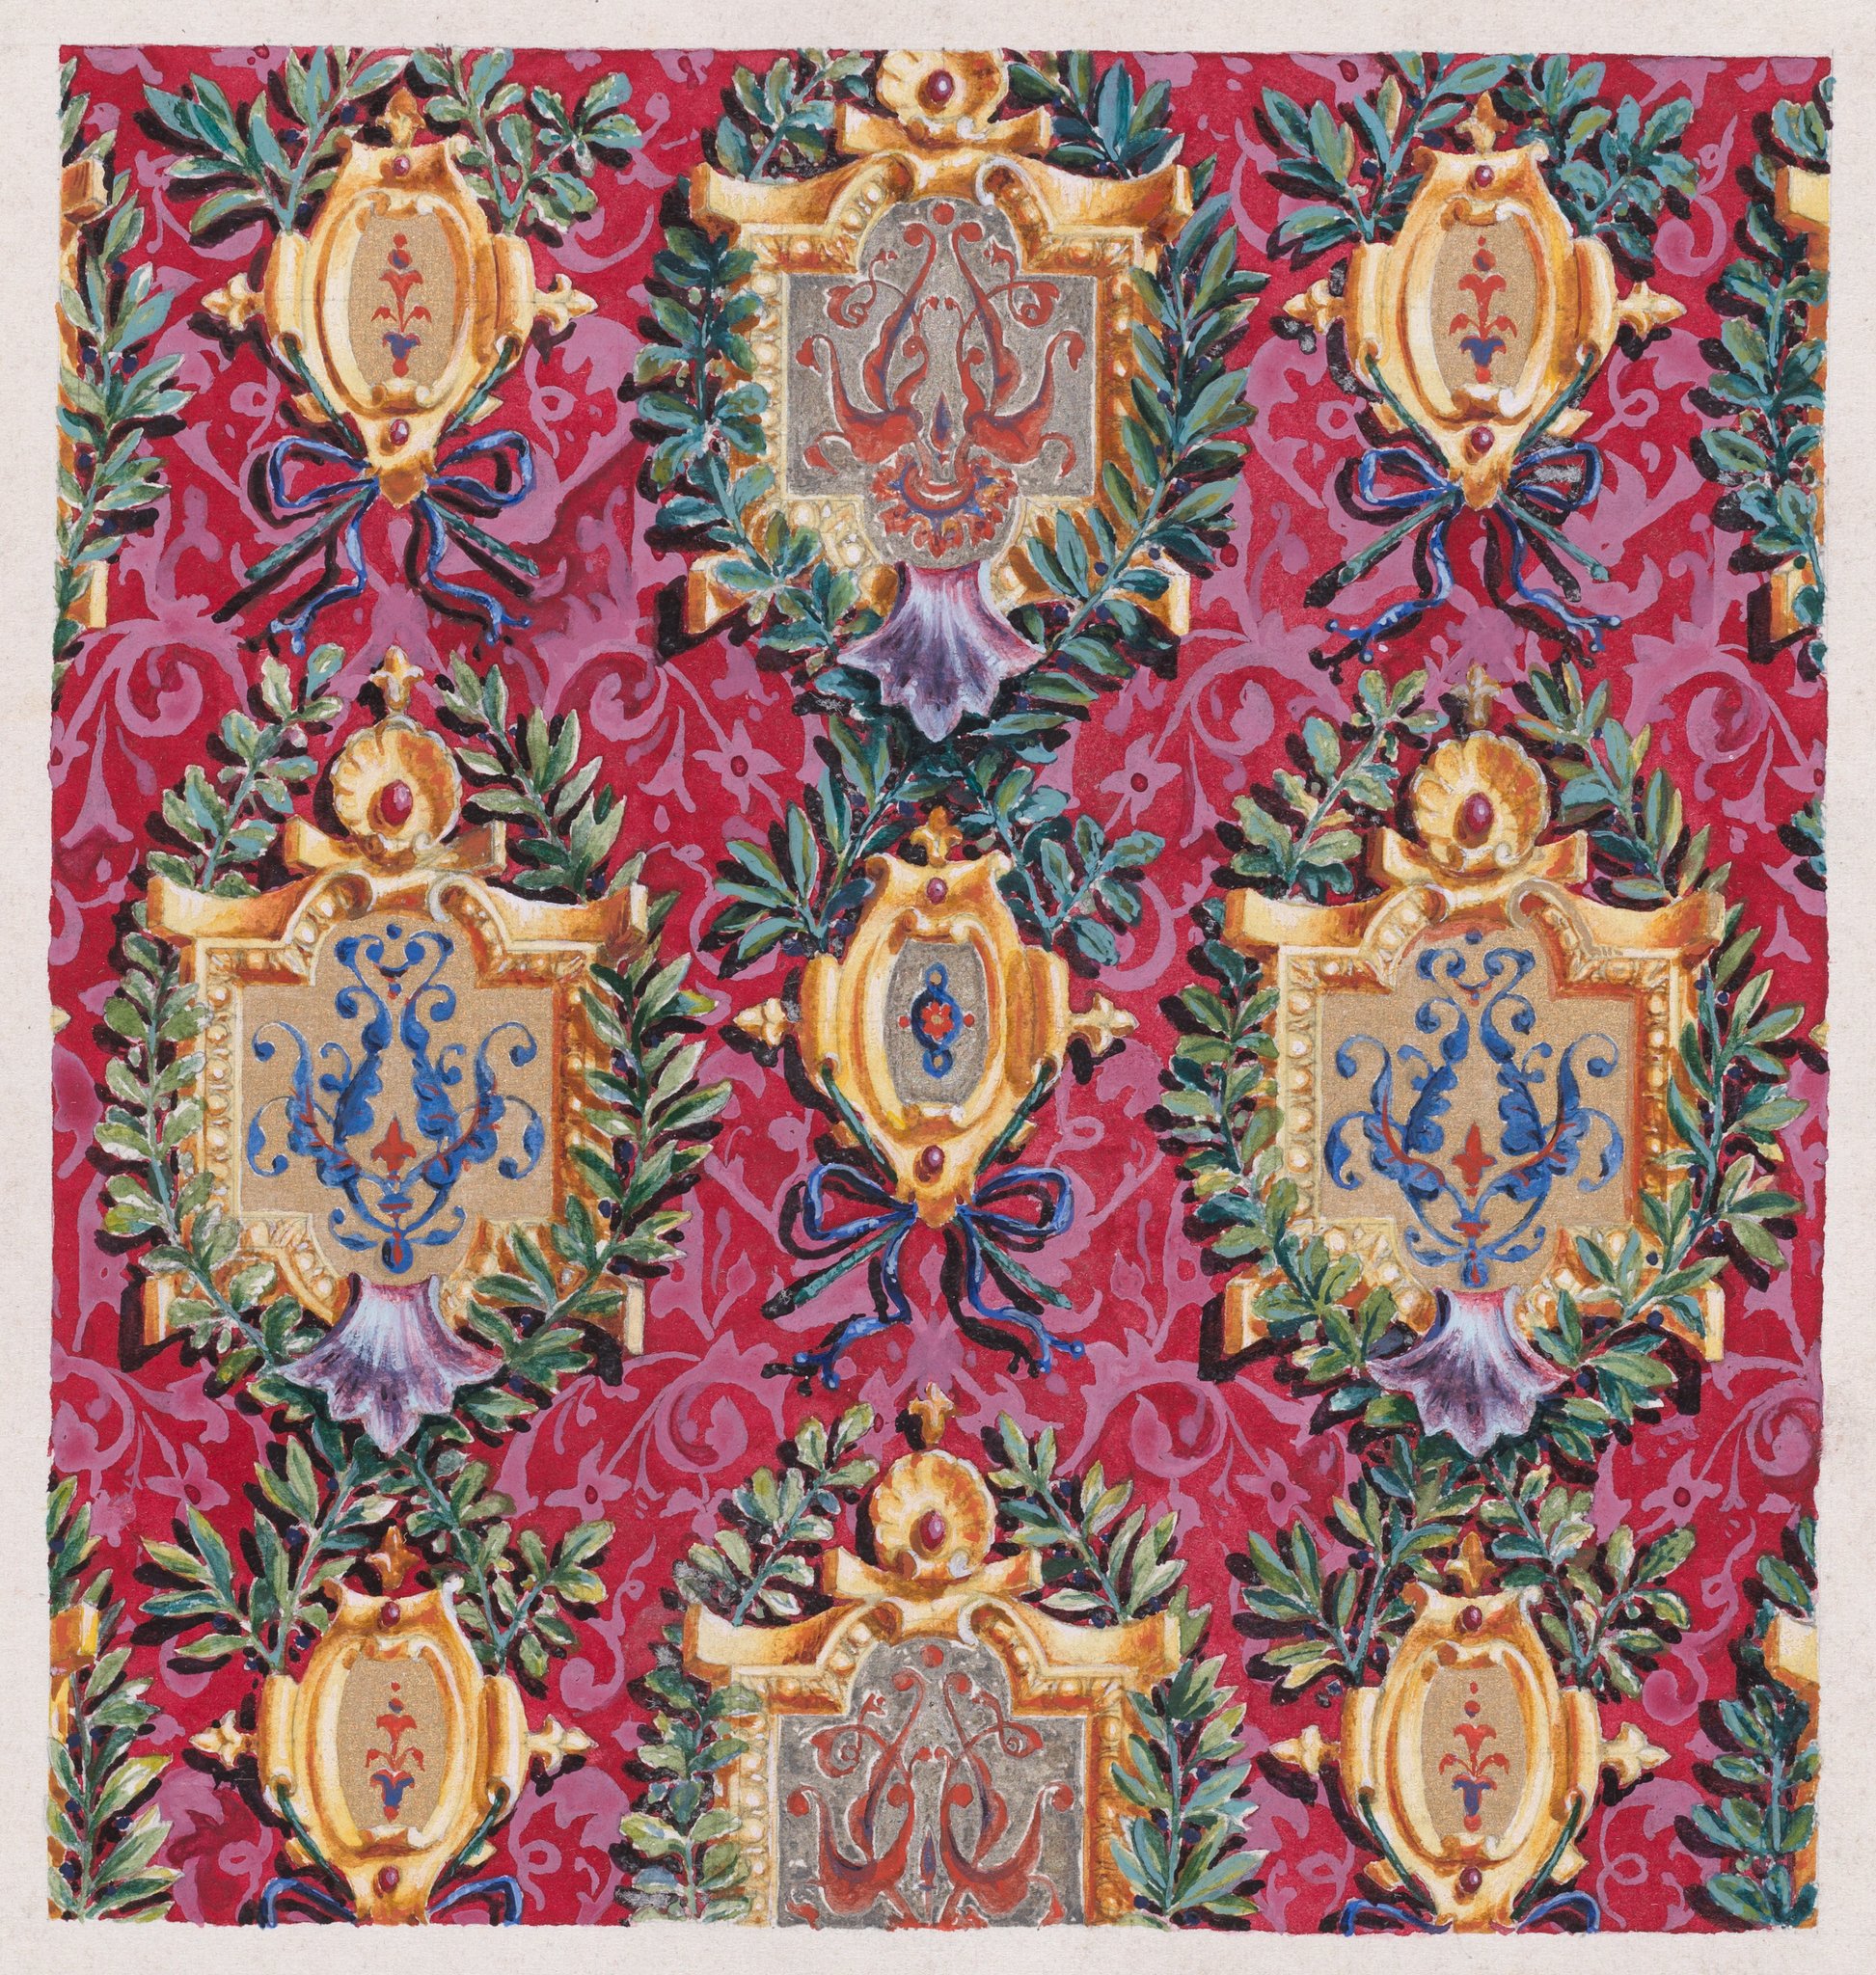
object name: drawing ornament architecture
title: Design for Wallpaper with Alternating Vertical Rows of Pairs of Ornamental Frames of Two Sizes Framed by Interlacing Garlands of Laurel Leaves Tied by a Bow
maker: anonymous, french, 19th century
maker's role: designer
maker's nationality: french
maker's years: 1800-1900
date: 1870-1900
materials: watercolor